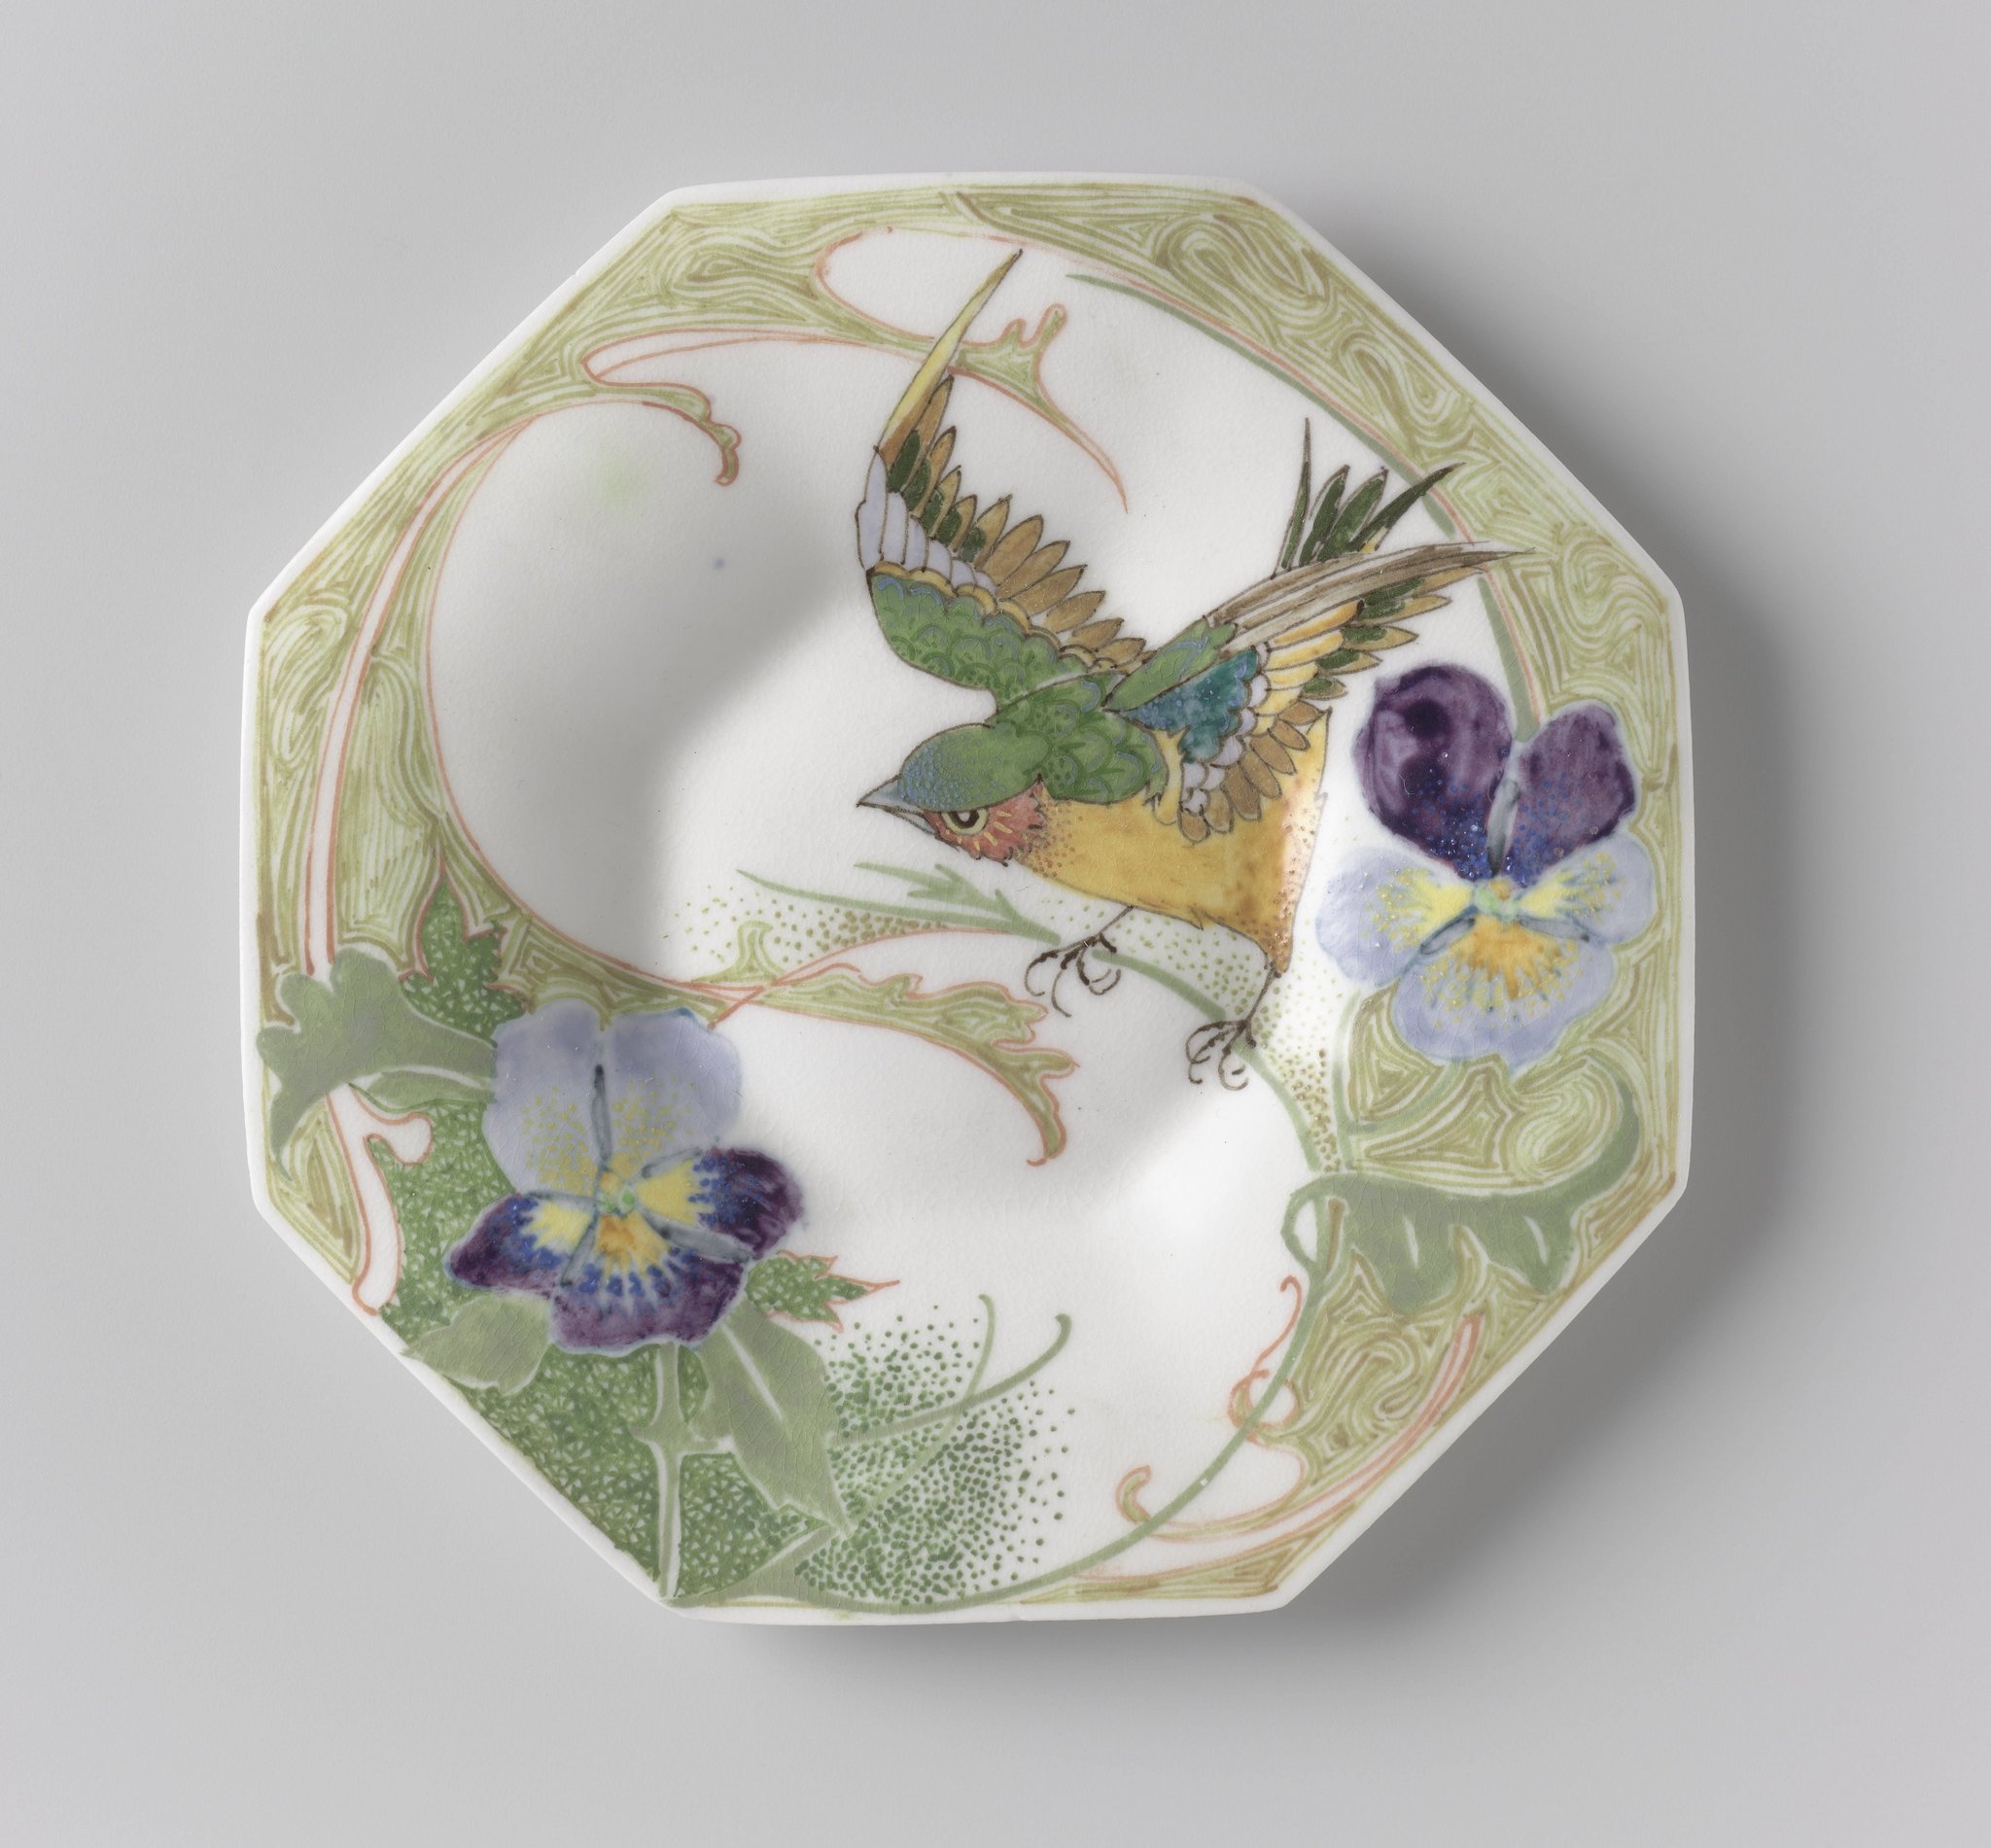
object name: platter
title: Schotel, deel van een servies, beschilderd met vogel en violen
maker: c.w.j. t hart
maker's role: plateelschilder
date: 1913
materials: porcelain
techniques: painted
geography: the hague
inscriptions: mark: ‘kroon, Rozenburg, ooievaar, den Haag (boven elkaar); links het merk voor 1913, rechts het werkordernummer 332 (op een kop 333); onder het schildersmerk van C.W.J. 't Hart.’